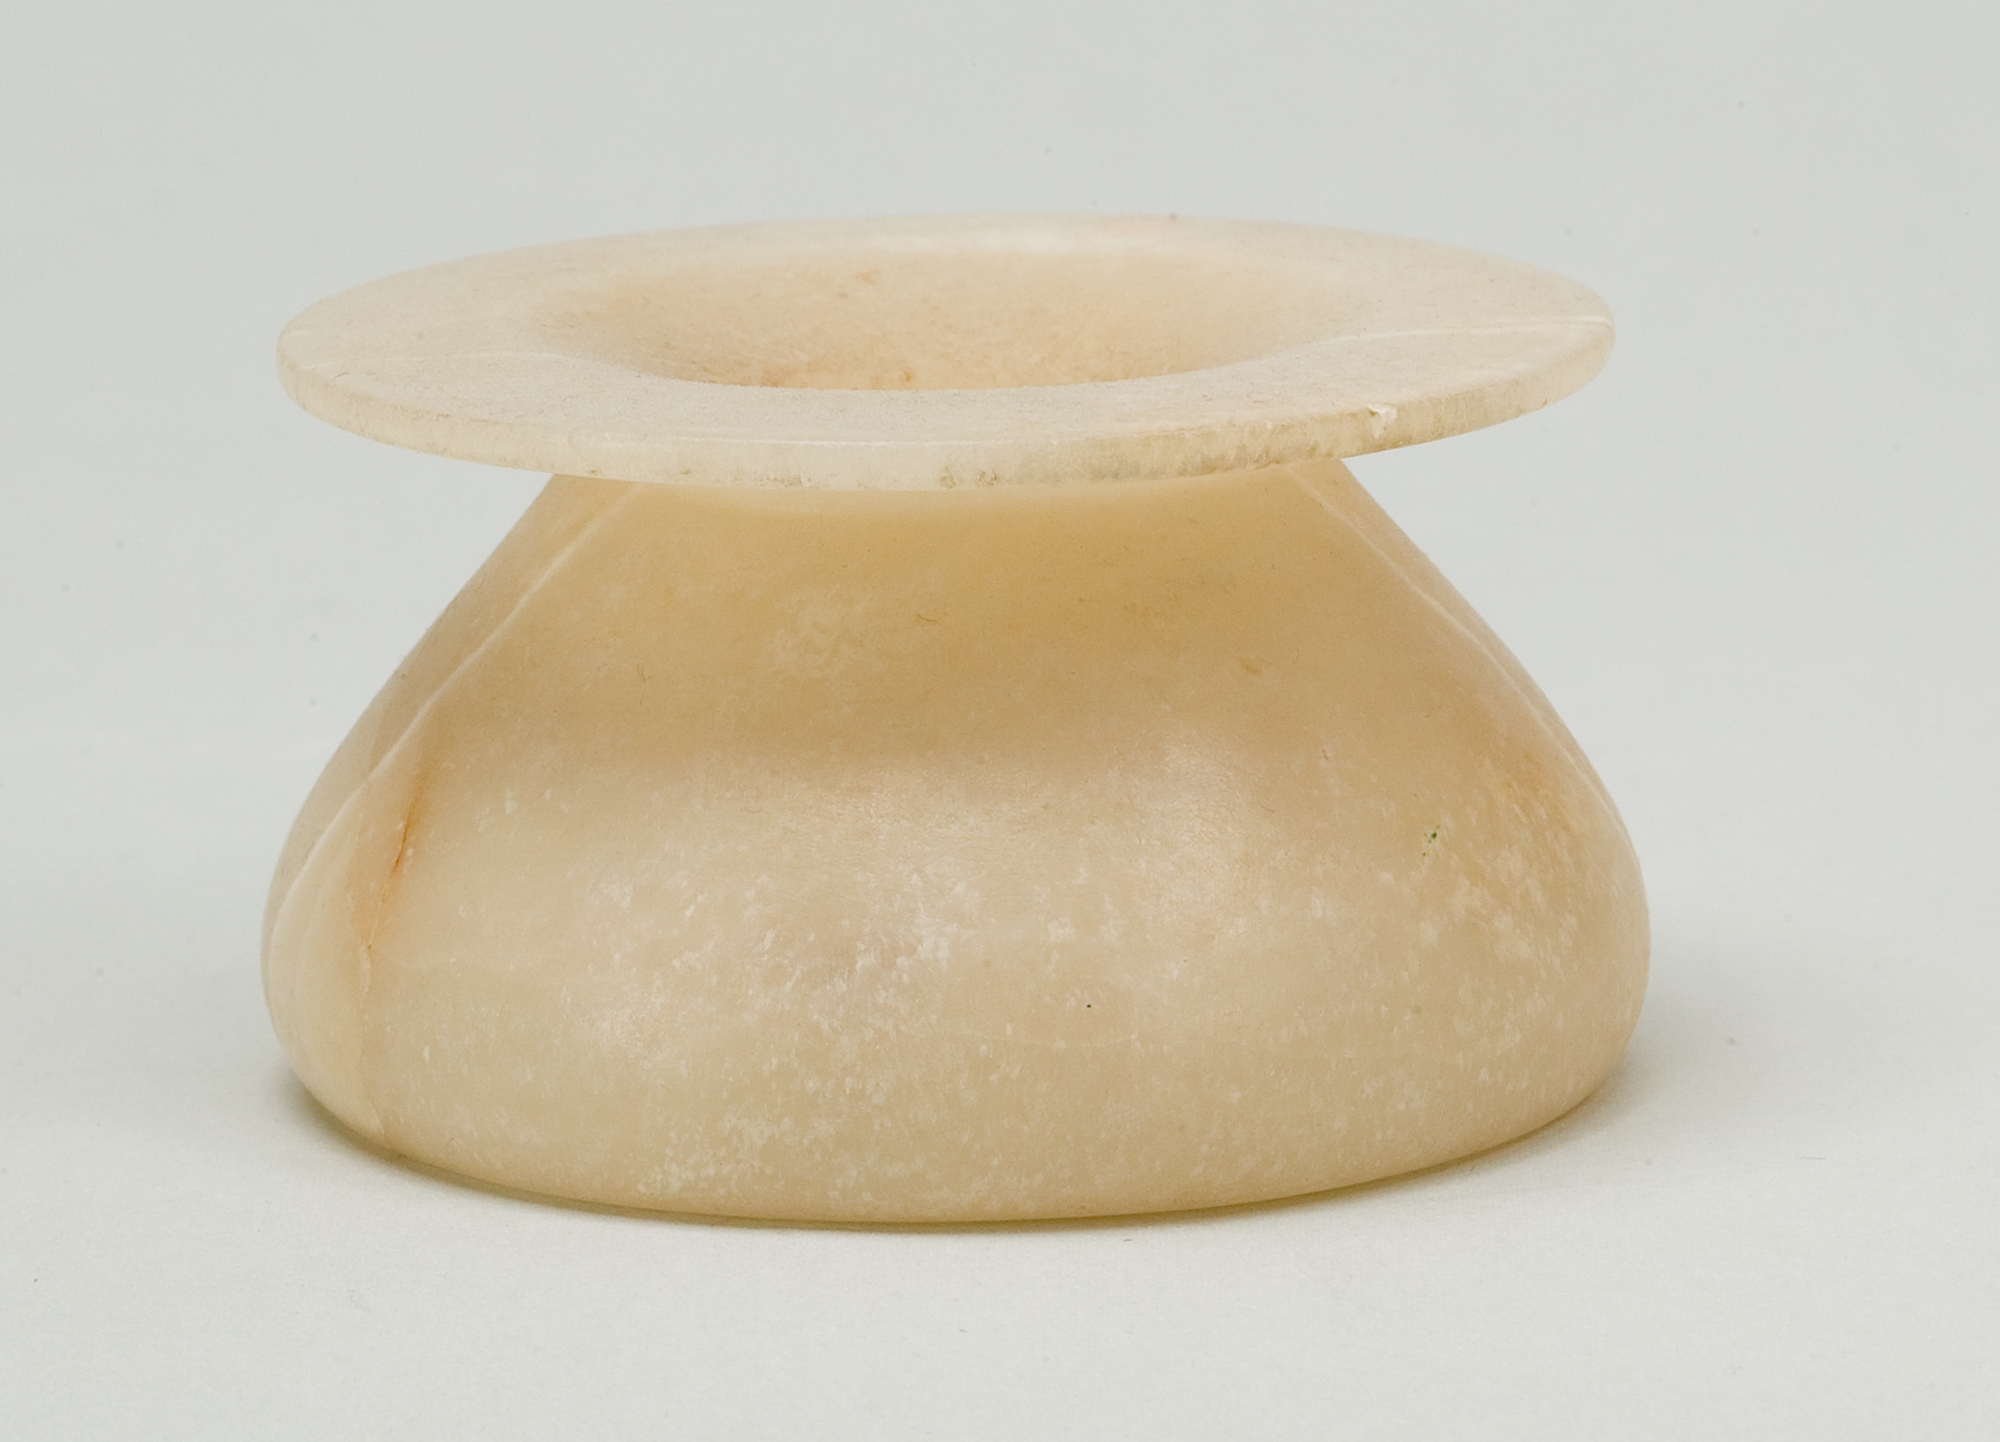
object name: cosmetic jar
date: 1991-1450 BCE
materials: stone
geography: egypt